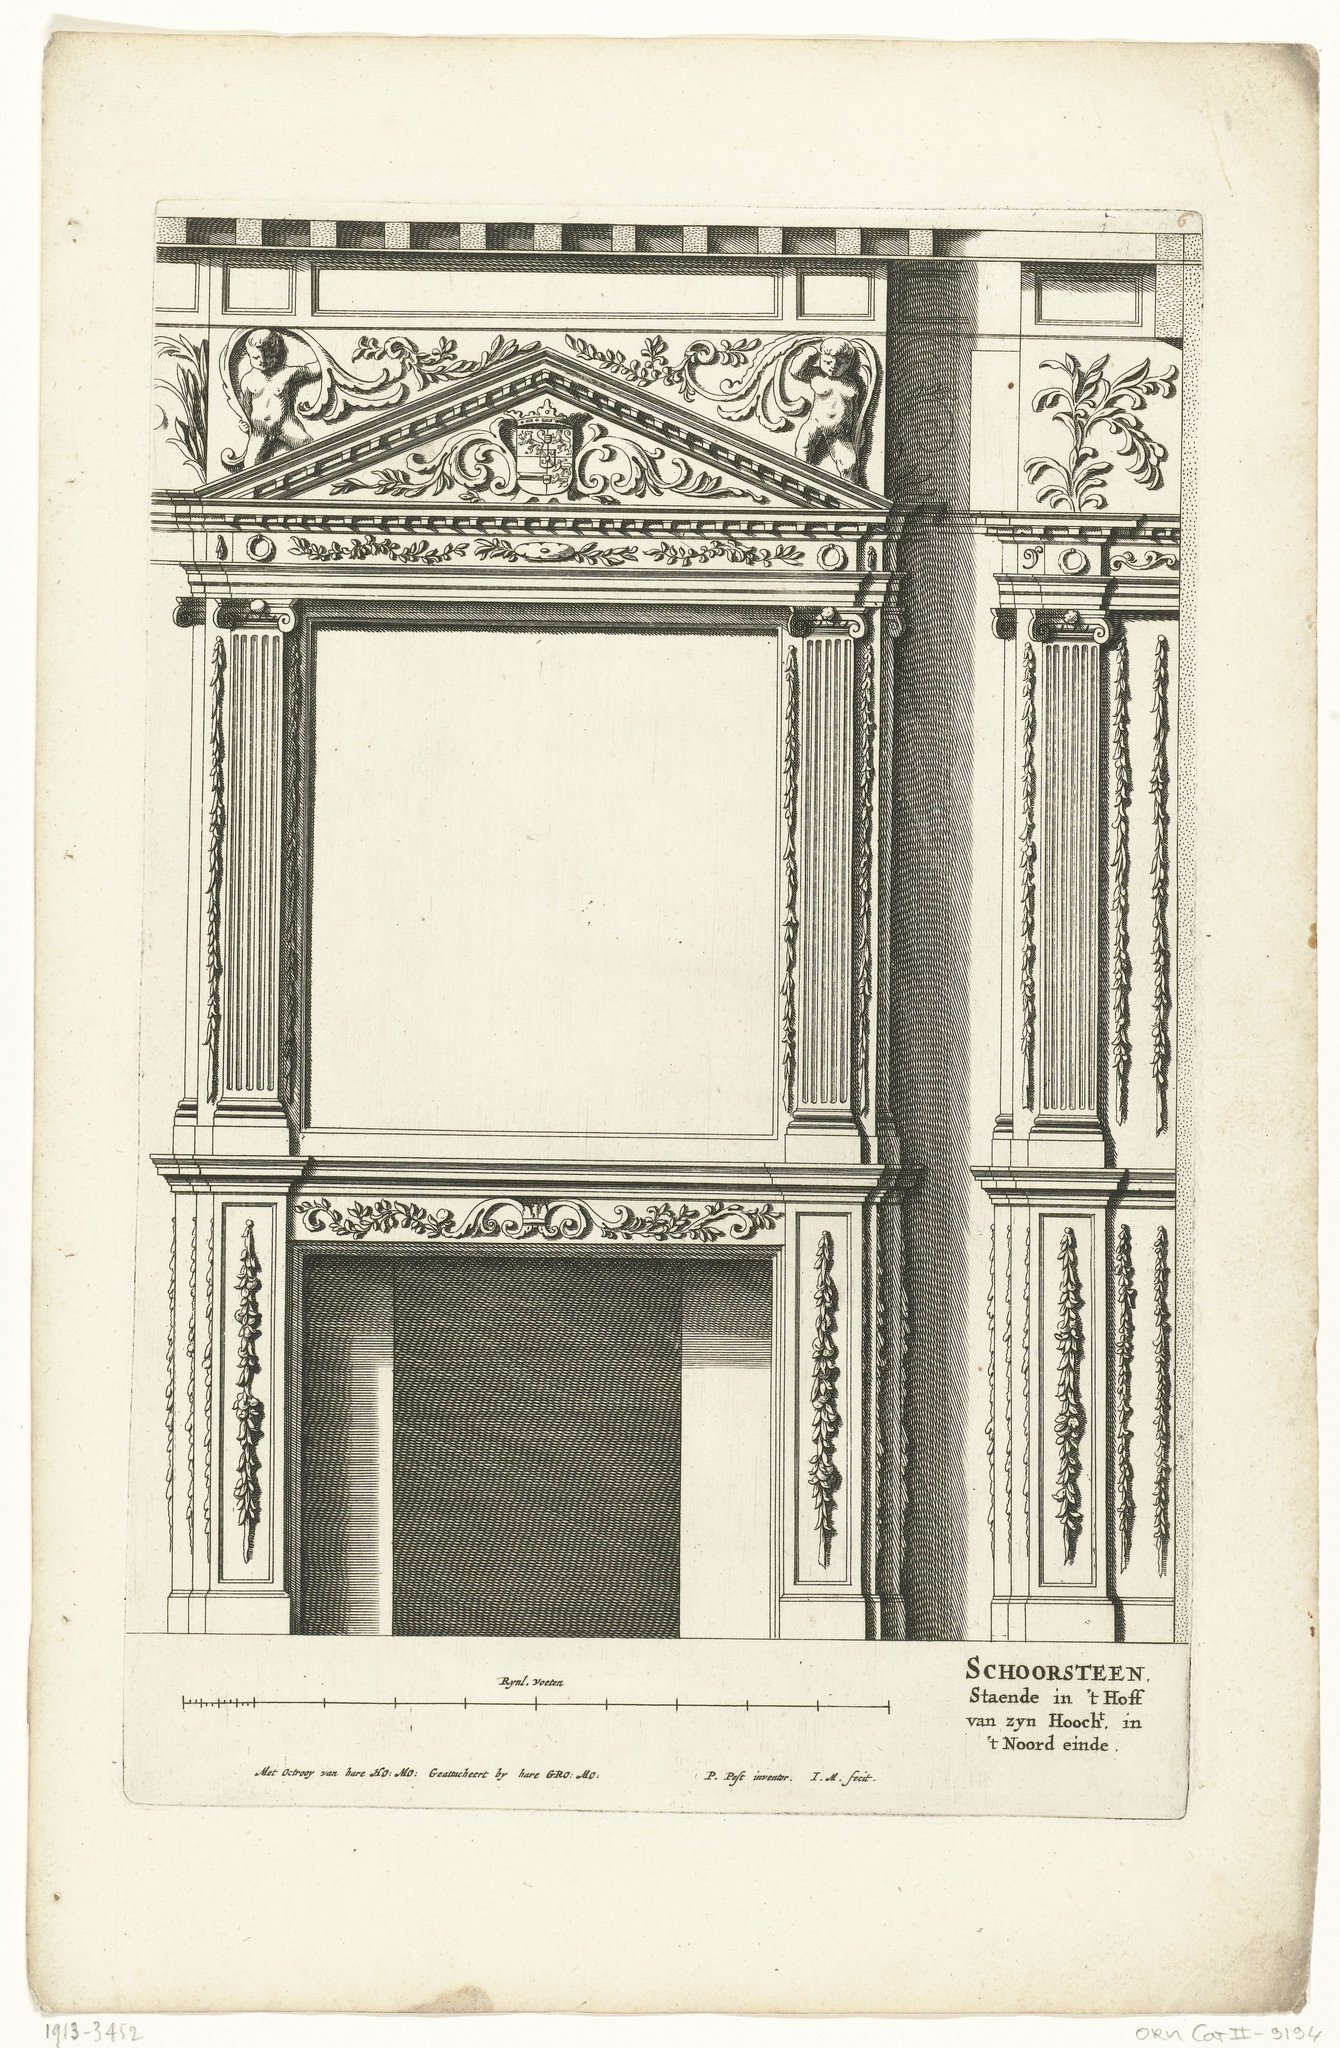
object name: ornament print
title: Schoorsteen Staende in 't Hoff van zyn Hoocht. in 't Noord einde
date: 1664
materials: paper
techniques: engraving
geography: the hague